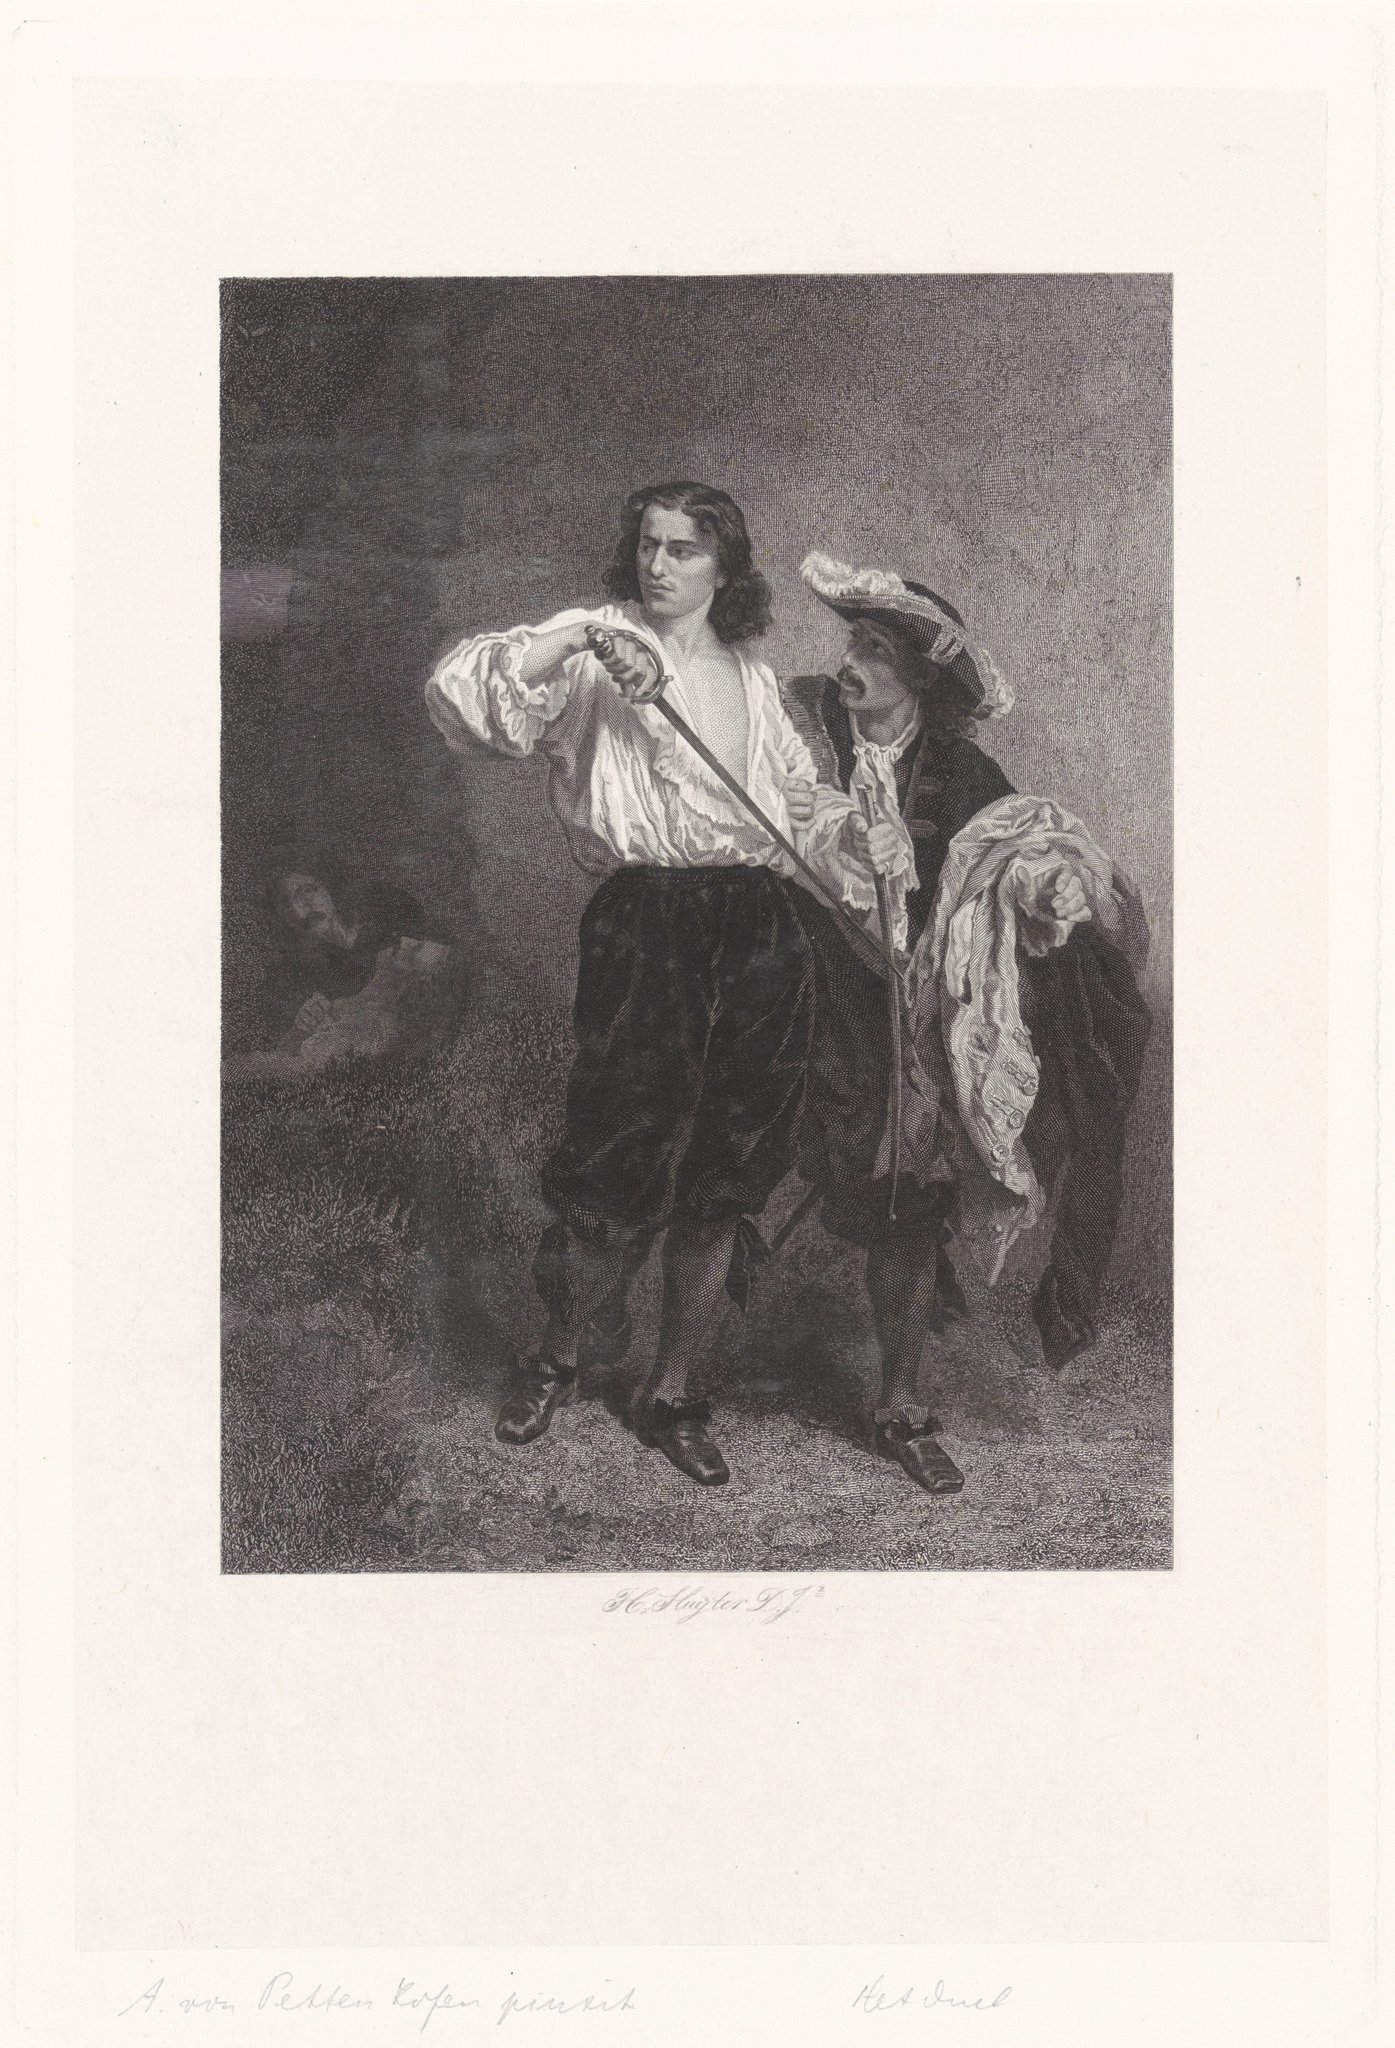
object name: print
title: Na het duel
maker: hendrik d. jzn sluyter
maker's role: print maker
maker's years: 1839-1931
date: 1854-1931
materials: paper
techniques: engraving, etching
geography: amsterdam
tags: duelling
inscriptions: inscription: ‘A. von Pettenkofen pinxit. Het duel.’ Lugt, collector's mark: 2165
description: Een man met een degen in de hand kijkt half over zijn schouder naar een gewonde man op de grond, die verzorgd wordt door een dienaar of vriend. De overwinnaar wordt aan zijn arm weggevoerd door een dienaar, die diens jas tijdens het duel bij zich gehouden heeft.